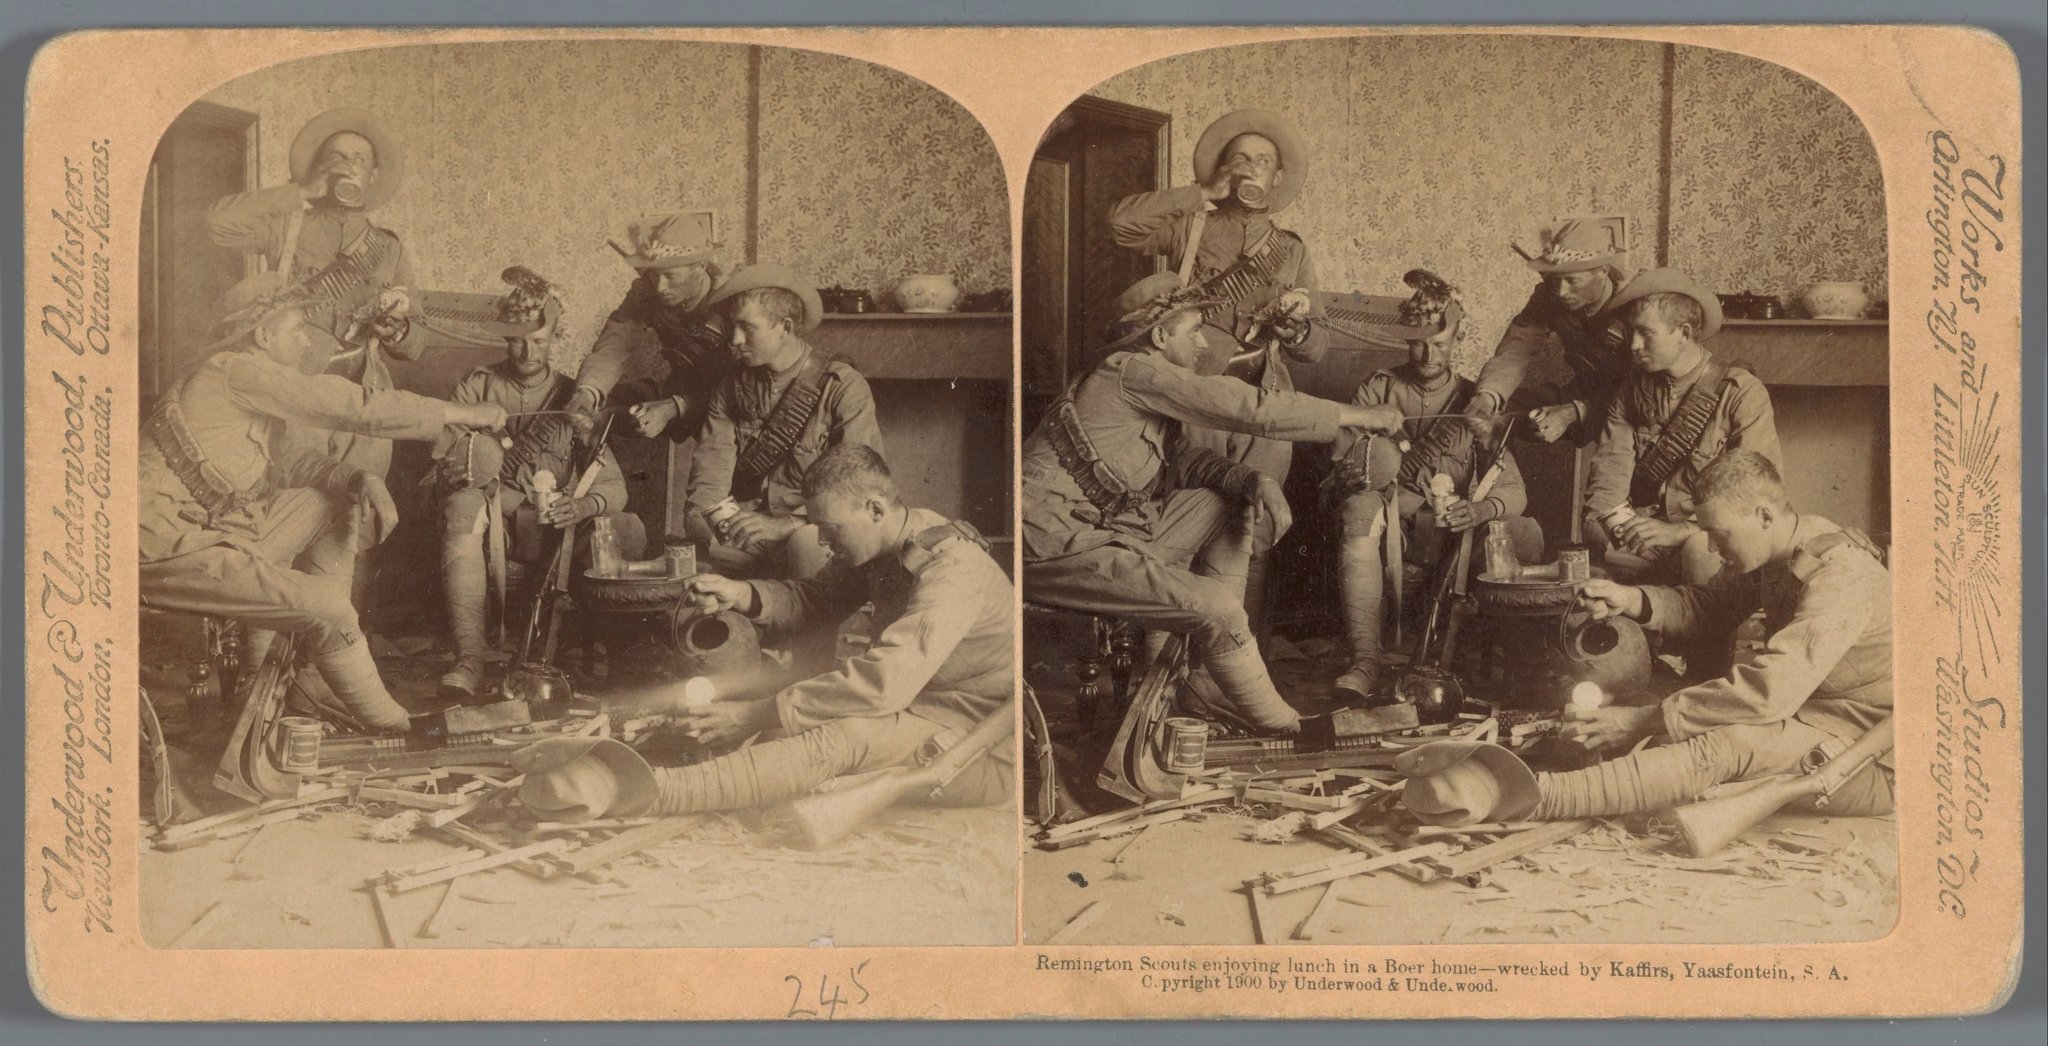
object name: stereograph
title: Remington Scouts enjoying lunch in a Boer home - wrecked by Kaffirs, Yaasfontein, South Africa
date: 1900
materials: cardboard, photographic support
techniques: albumen print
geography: south africa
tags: midday meal, lunch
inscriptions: name: ‘Works and Studios Sun Sculpture trade mark Arlington N.J. Littleton N.H. Washington D.C.’, number: ‘245’